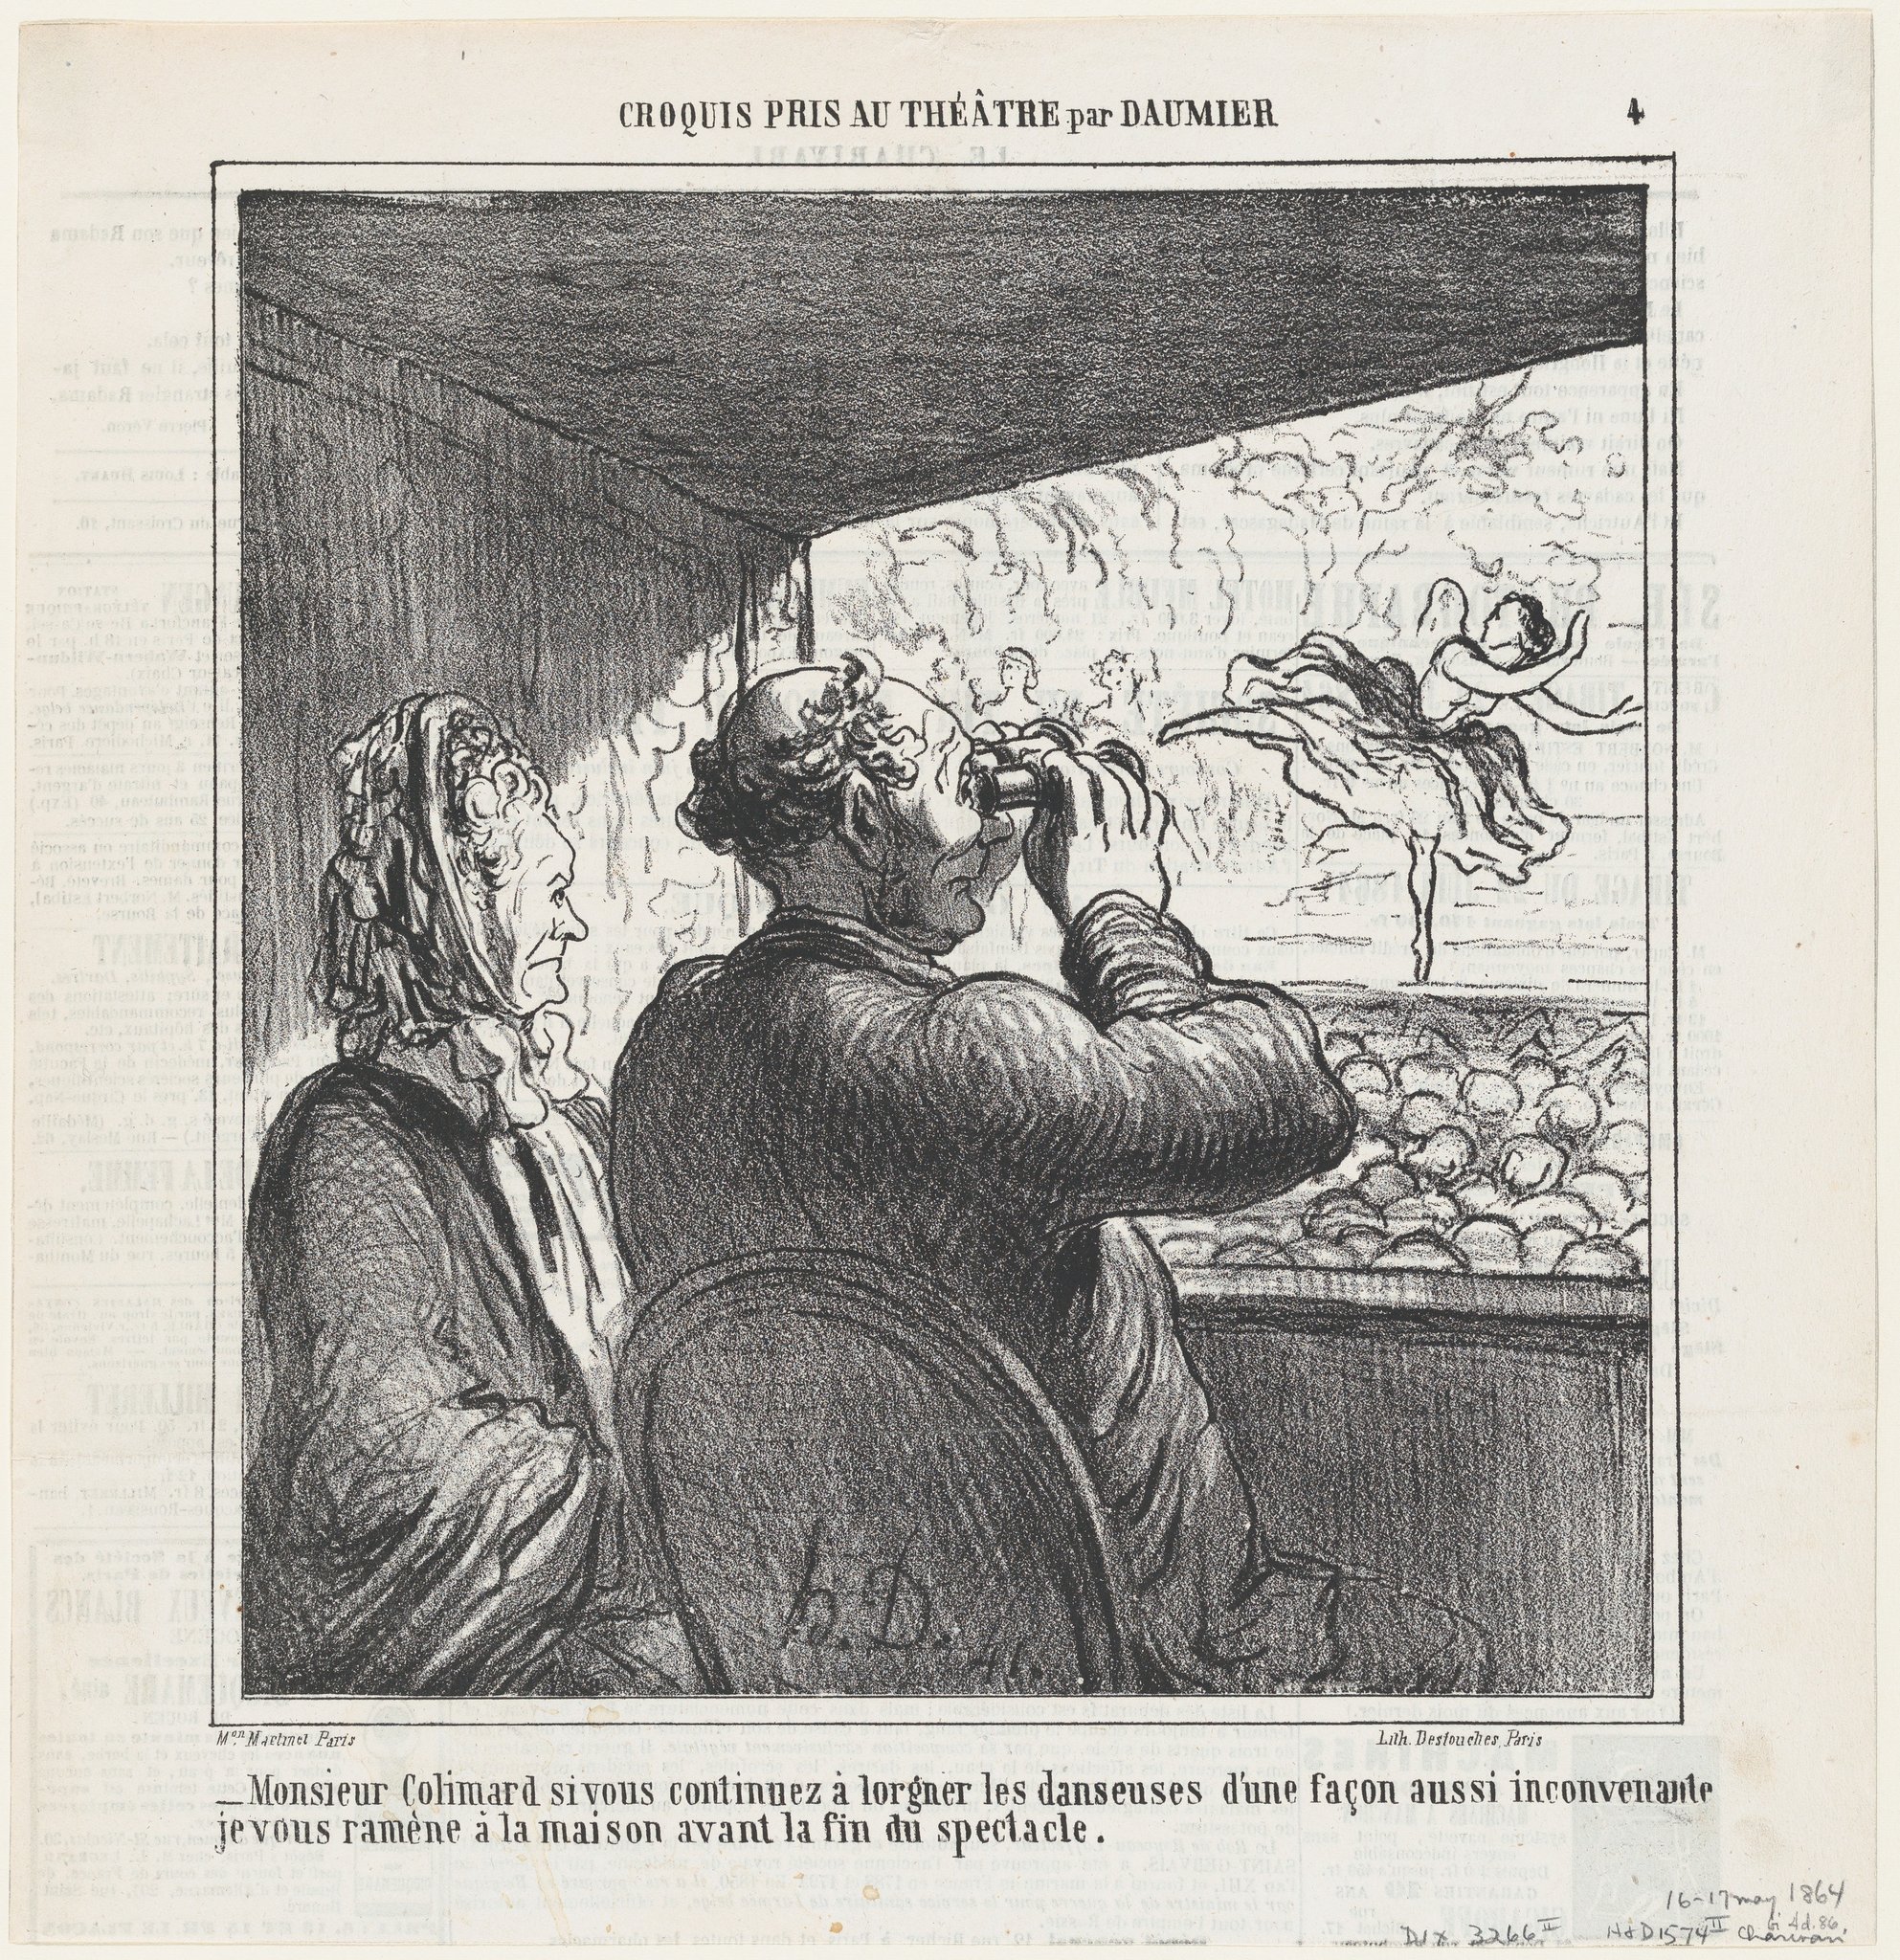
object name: print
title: Mr. Colimard, if you don't immediately stop ogling the dancers..., from 'Theater sketches,' published in Le Charivari, May 4, 1864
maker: honoré daumier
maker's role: artist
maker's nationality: french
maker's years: 1808-1879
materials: paper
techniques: lithograph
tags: dance,men,women,dancers